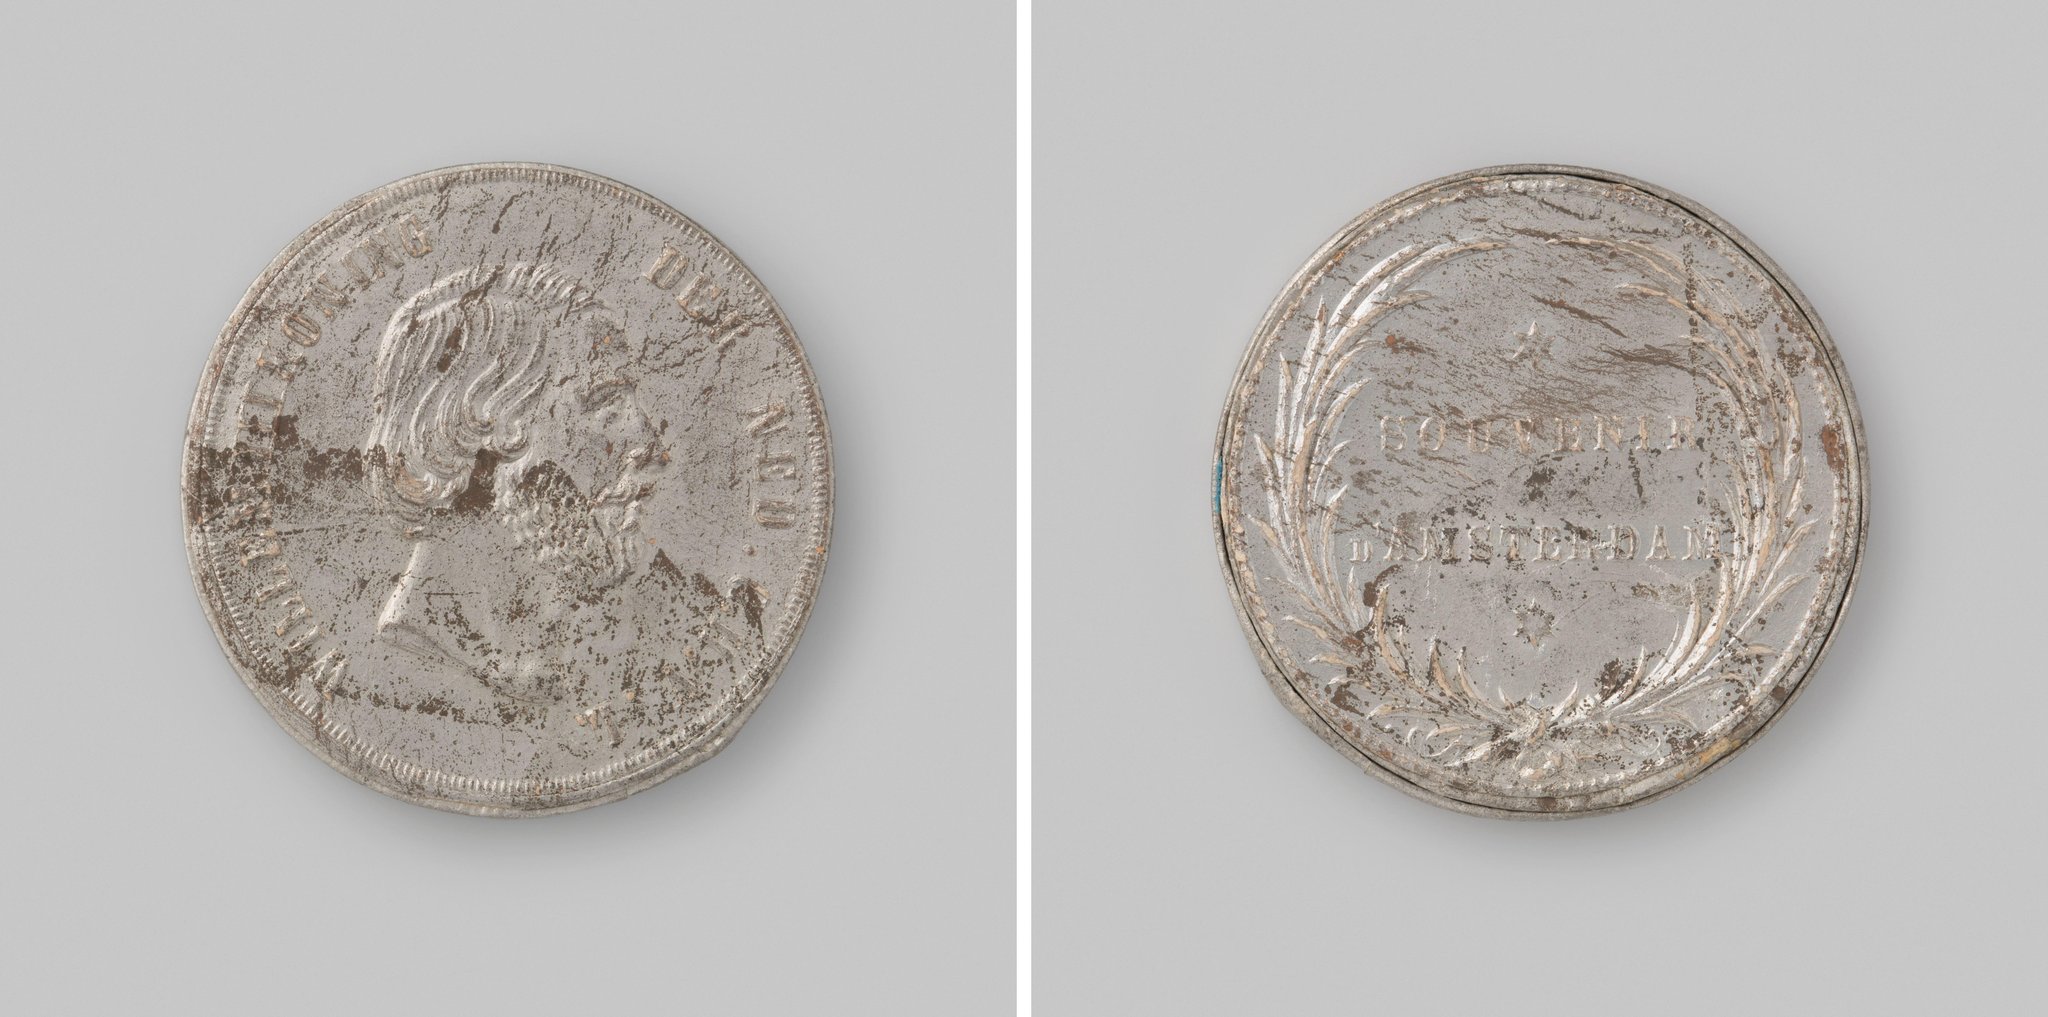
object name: history medal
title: Muntvormig doosje met foto's "Souvenir d' Amsterdam" 1870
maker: g. theod. bom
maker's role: publisher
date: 1870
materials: aluminum, paper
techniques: pressing, printing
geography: amsterdam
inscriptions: circumscription: ‘WILLEM III KONING - DER NED. G.H.V.L.’, inscription: ‘SOUVENIR / D' AMSTERDAM’, inscription: ‘G. Th. BOM / Éditeur, / Kalverstraat, / AMSTERDAM. / Toute Contrefaçon sera / poursuivie conformé- / ment à la loi !’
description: Muntvormig doosje van geperst aluminiumfolie, met kartelrand, op de voorzijde het portret van Koning Willem III met omschrift, op de keerzijde twee regels tekst met onder en boven een ster tussen samengestrikte palmtakken, in het doosje 17 aaneenzittende ronde kartonnen plaatjes met fotografische afbeeldingen van gebouwen in Amsterdam en 1 plaatje met adresgegevens van de uitgever.